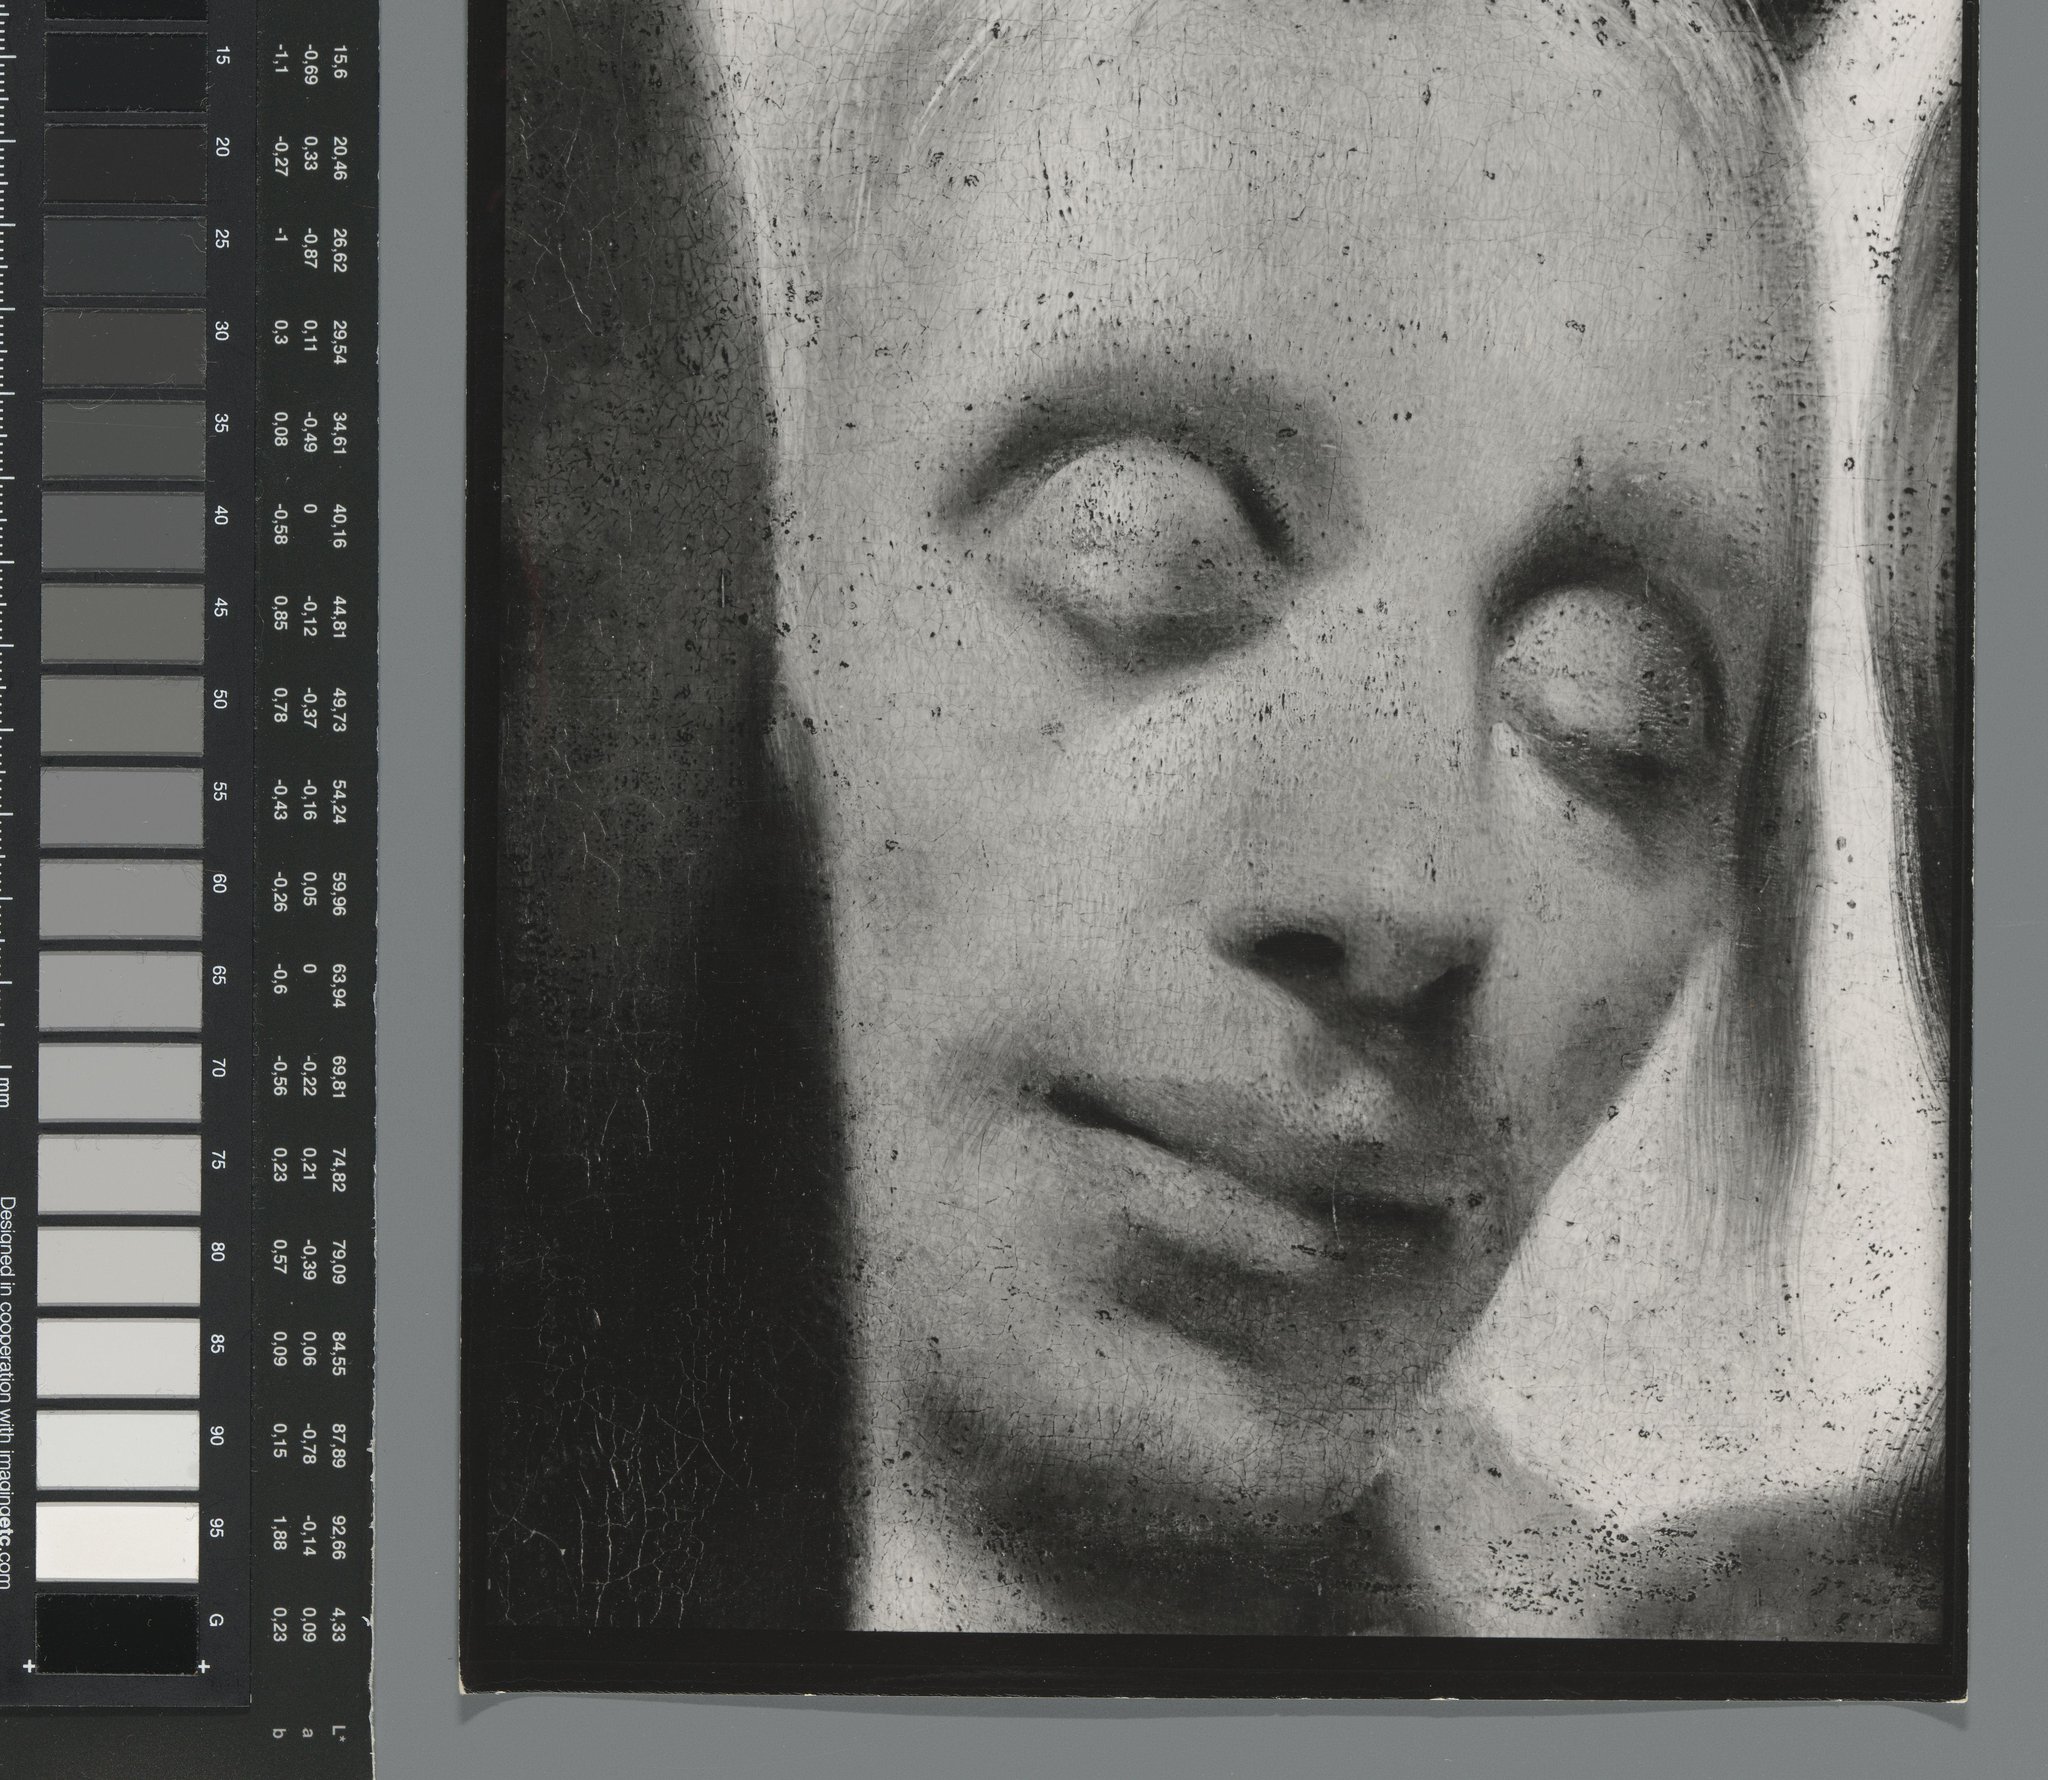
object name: photograph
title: Fotografische reproductie van een (detail) schilderij van Han van Meegeren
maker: nico zomer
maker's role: fotograaf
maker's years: 1910-1988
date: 1908-1948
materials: photographic support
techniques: gelatin silver print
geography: amsterdam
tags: picture, painting